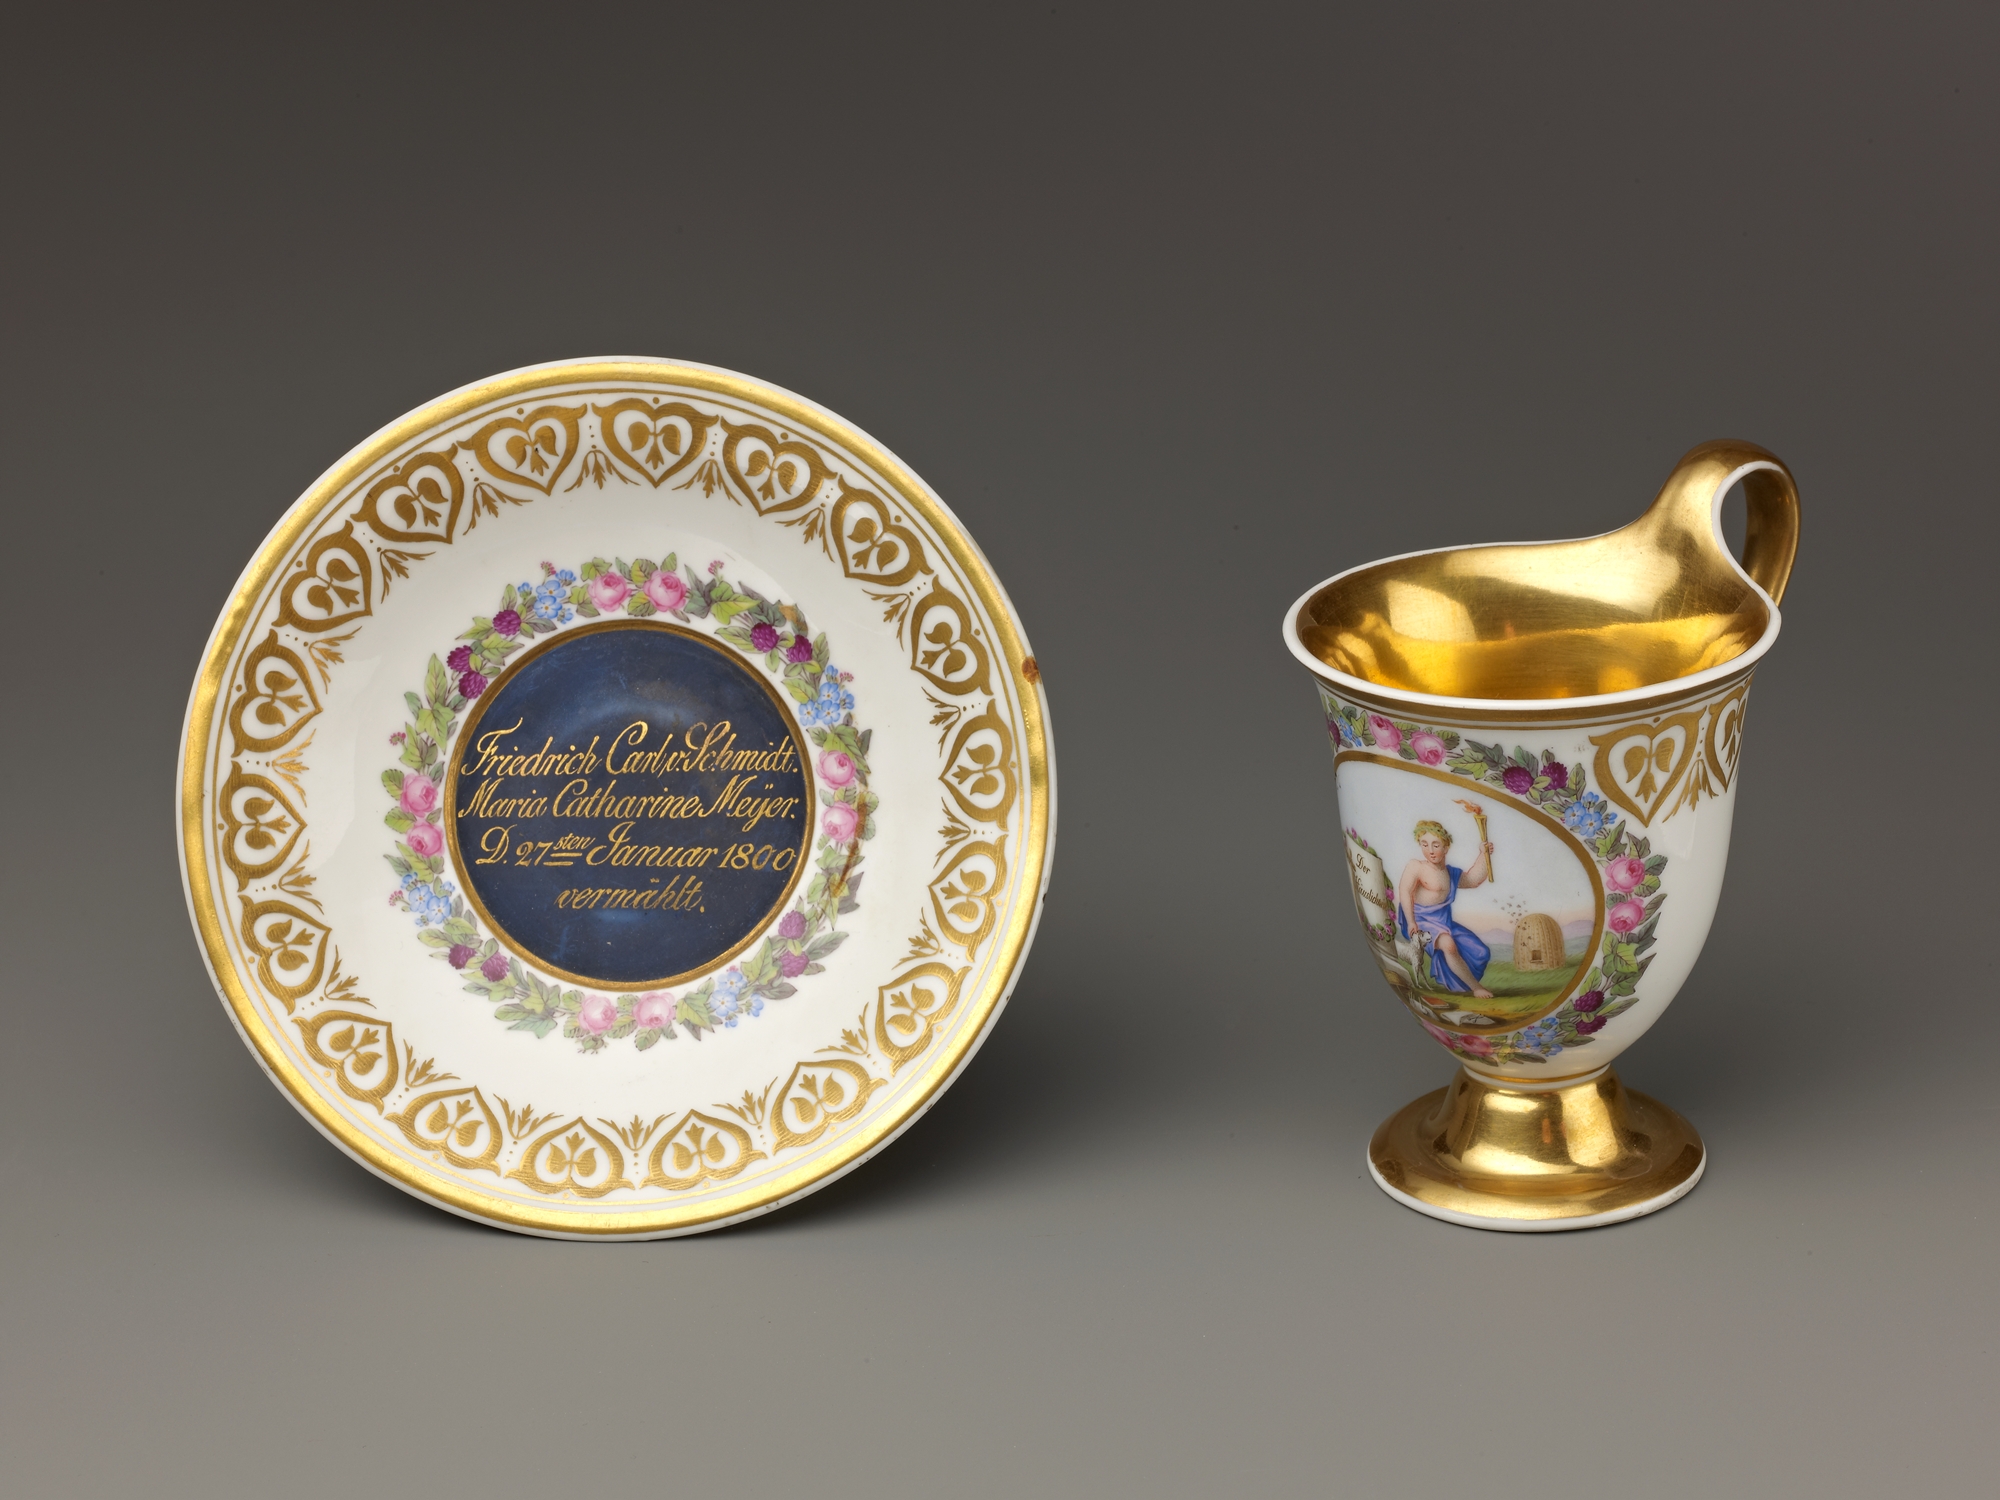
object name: cup and saucer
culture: german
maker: royal porcelain manufactory (königliche porzellan-manufaktur), berlin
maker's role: artist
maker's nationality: german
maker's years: 1763-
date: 1825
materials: hard paste porcelain